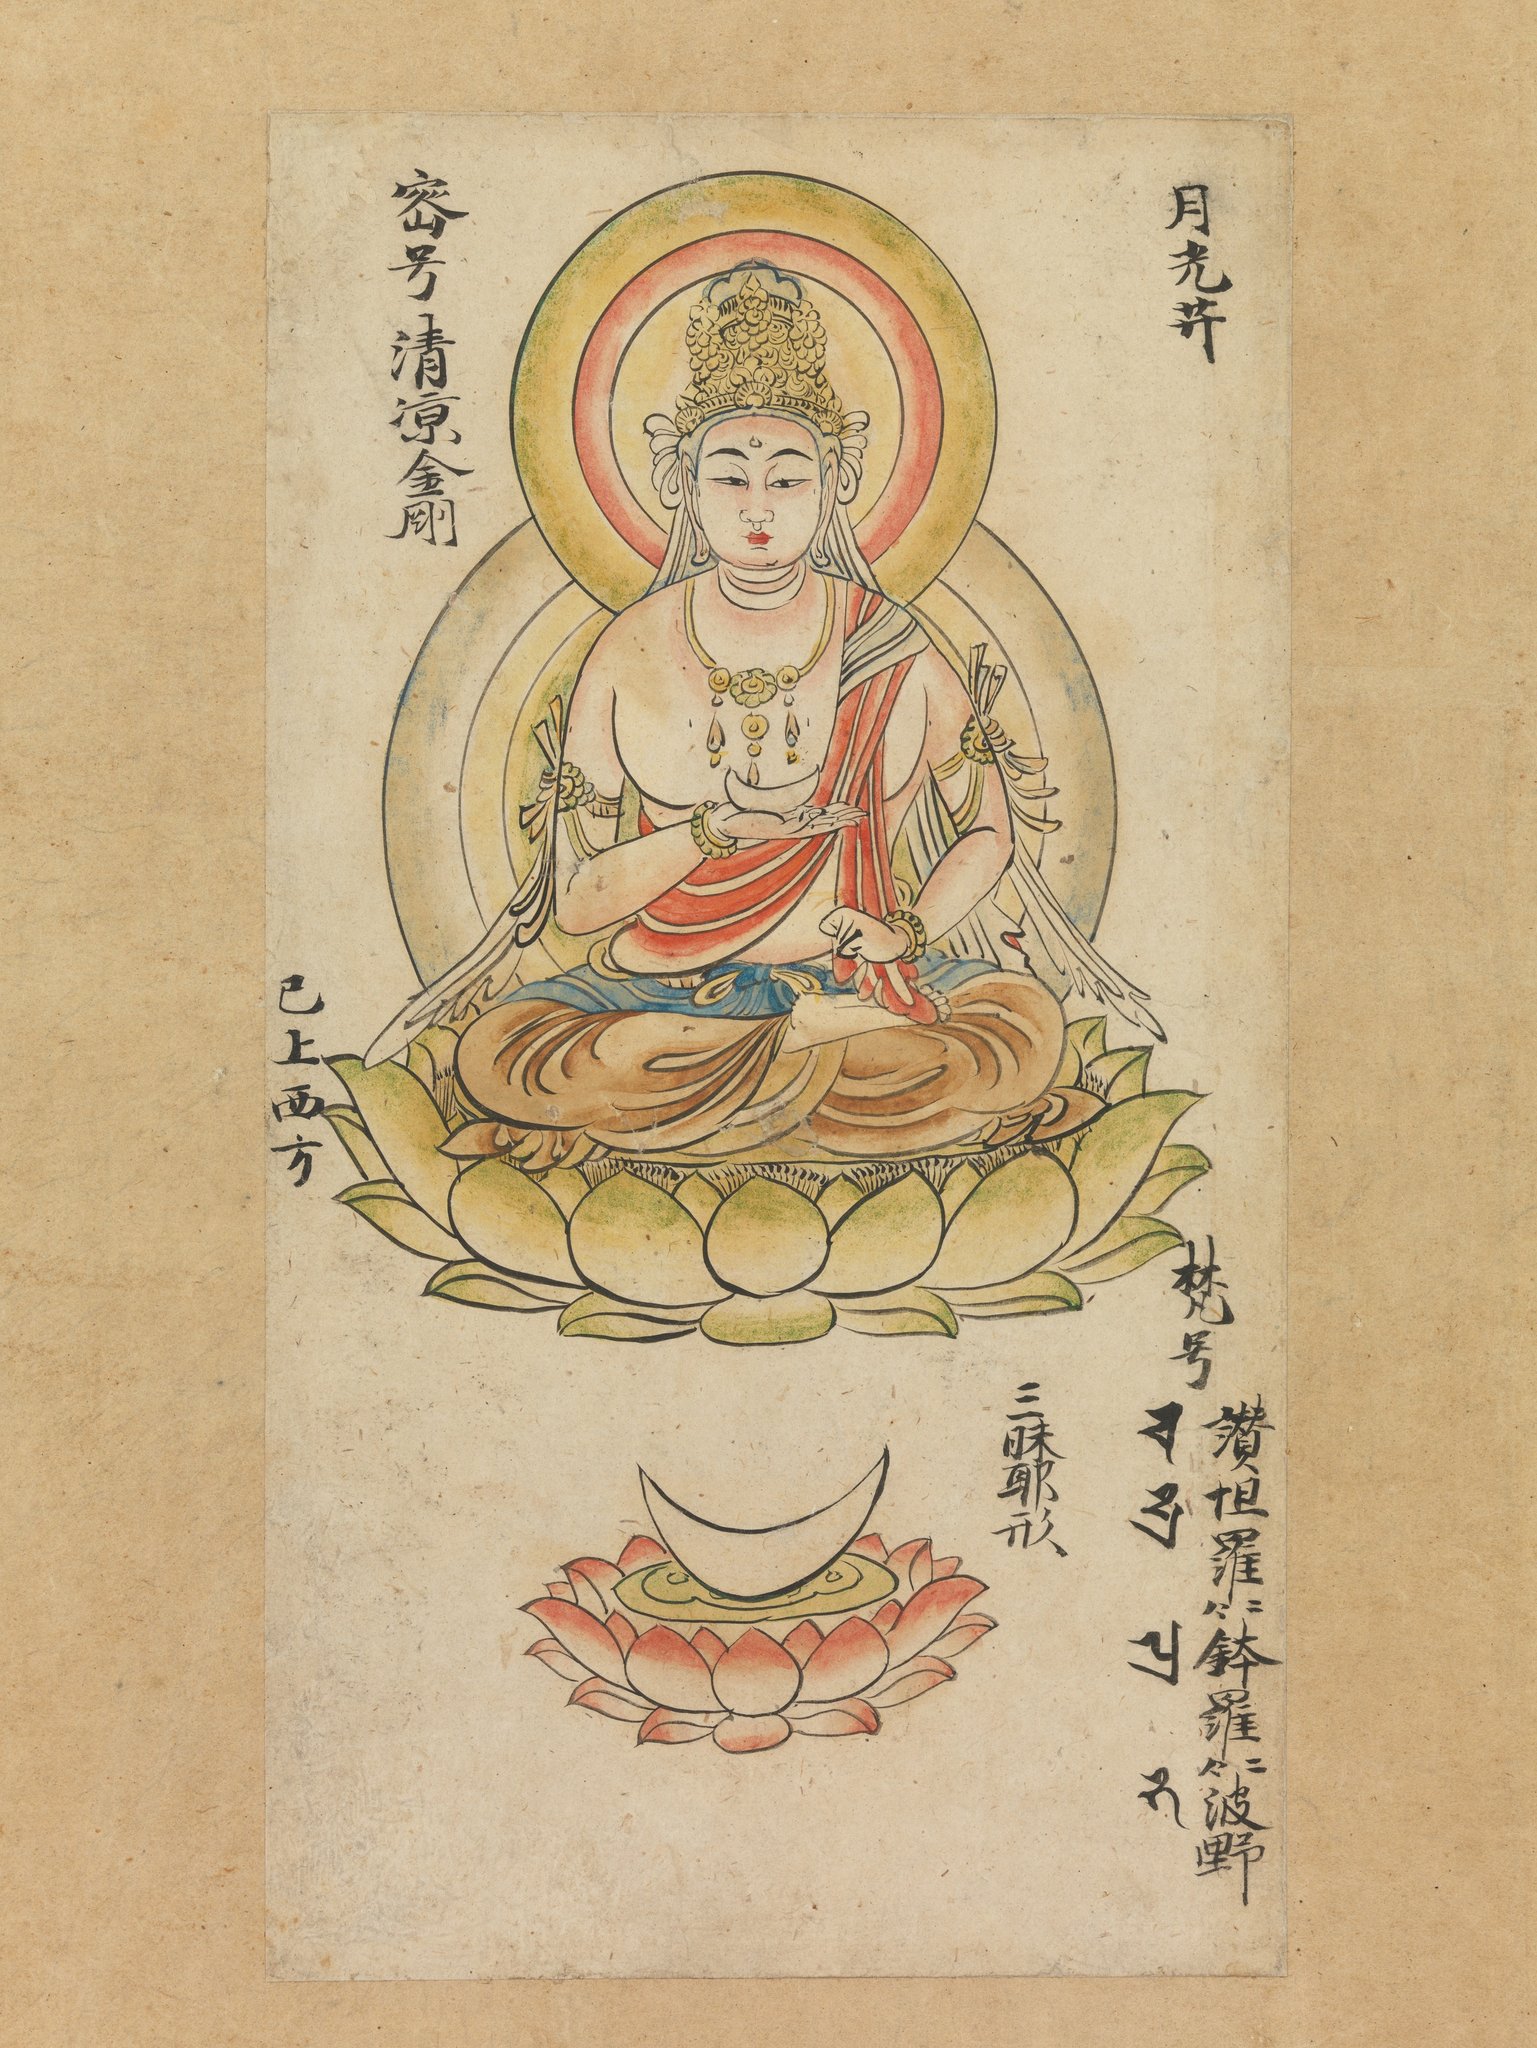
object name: hanging scroll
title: Gakkō Bosatsu, from “Album of Buddhist Deities from the Diamond World and Womb World Mandalas” (“Kontai butsugajō”)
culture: japanese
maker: takuma tametō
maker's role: artist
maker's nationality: japanese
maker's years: 1132-1174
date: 1134-1166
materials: gold, ink, paper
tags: moon,buddhism,bodhisattvas